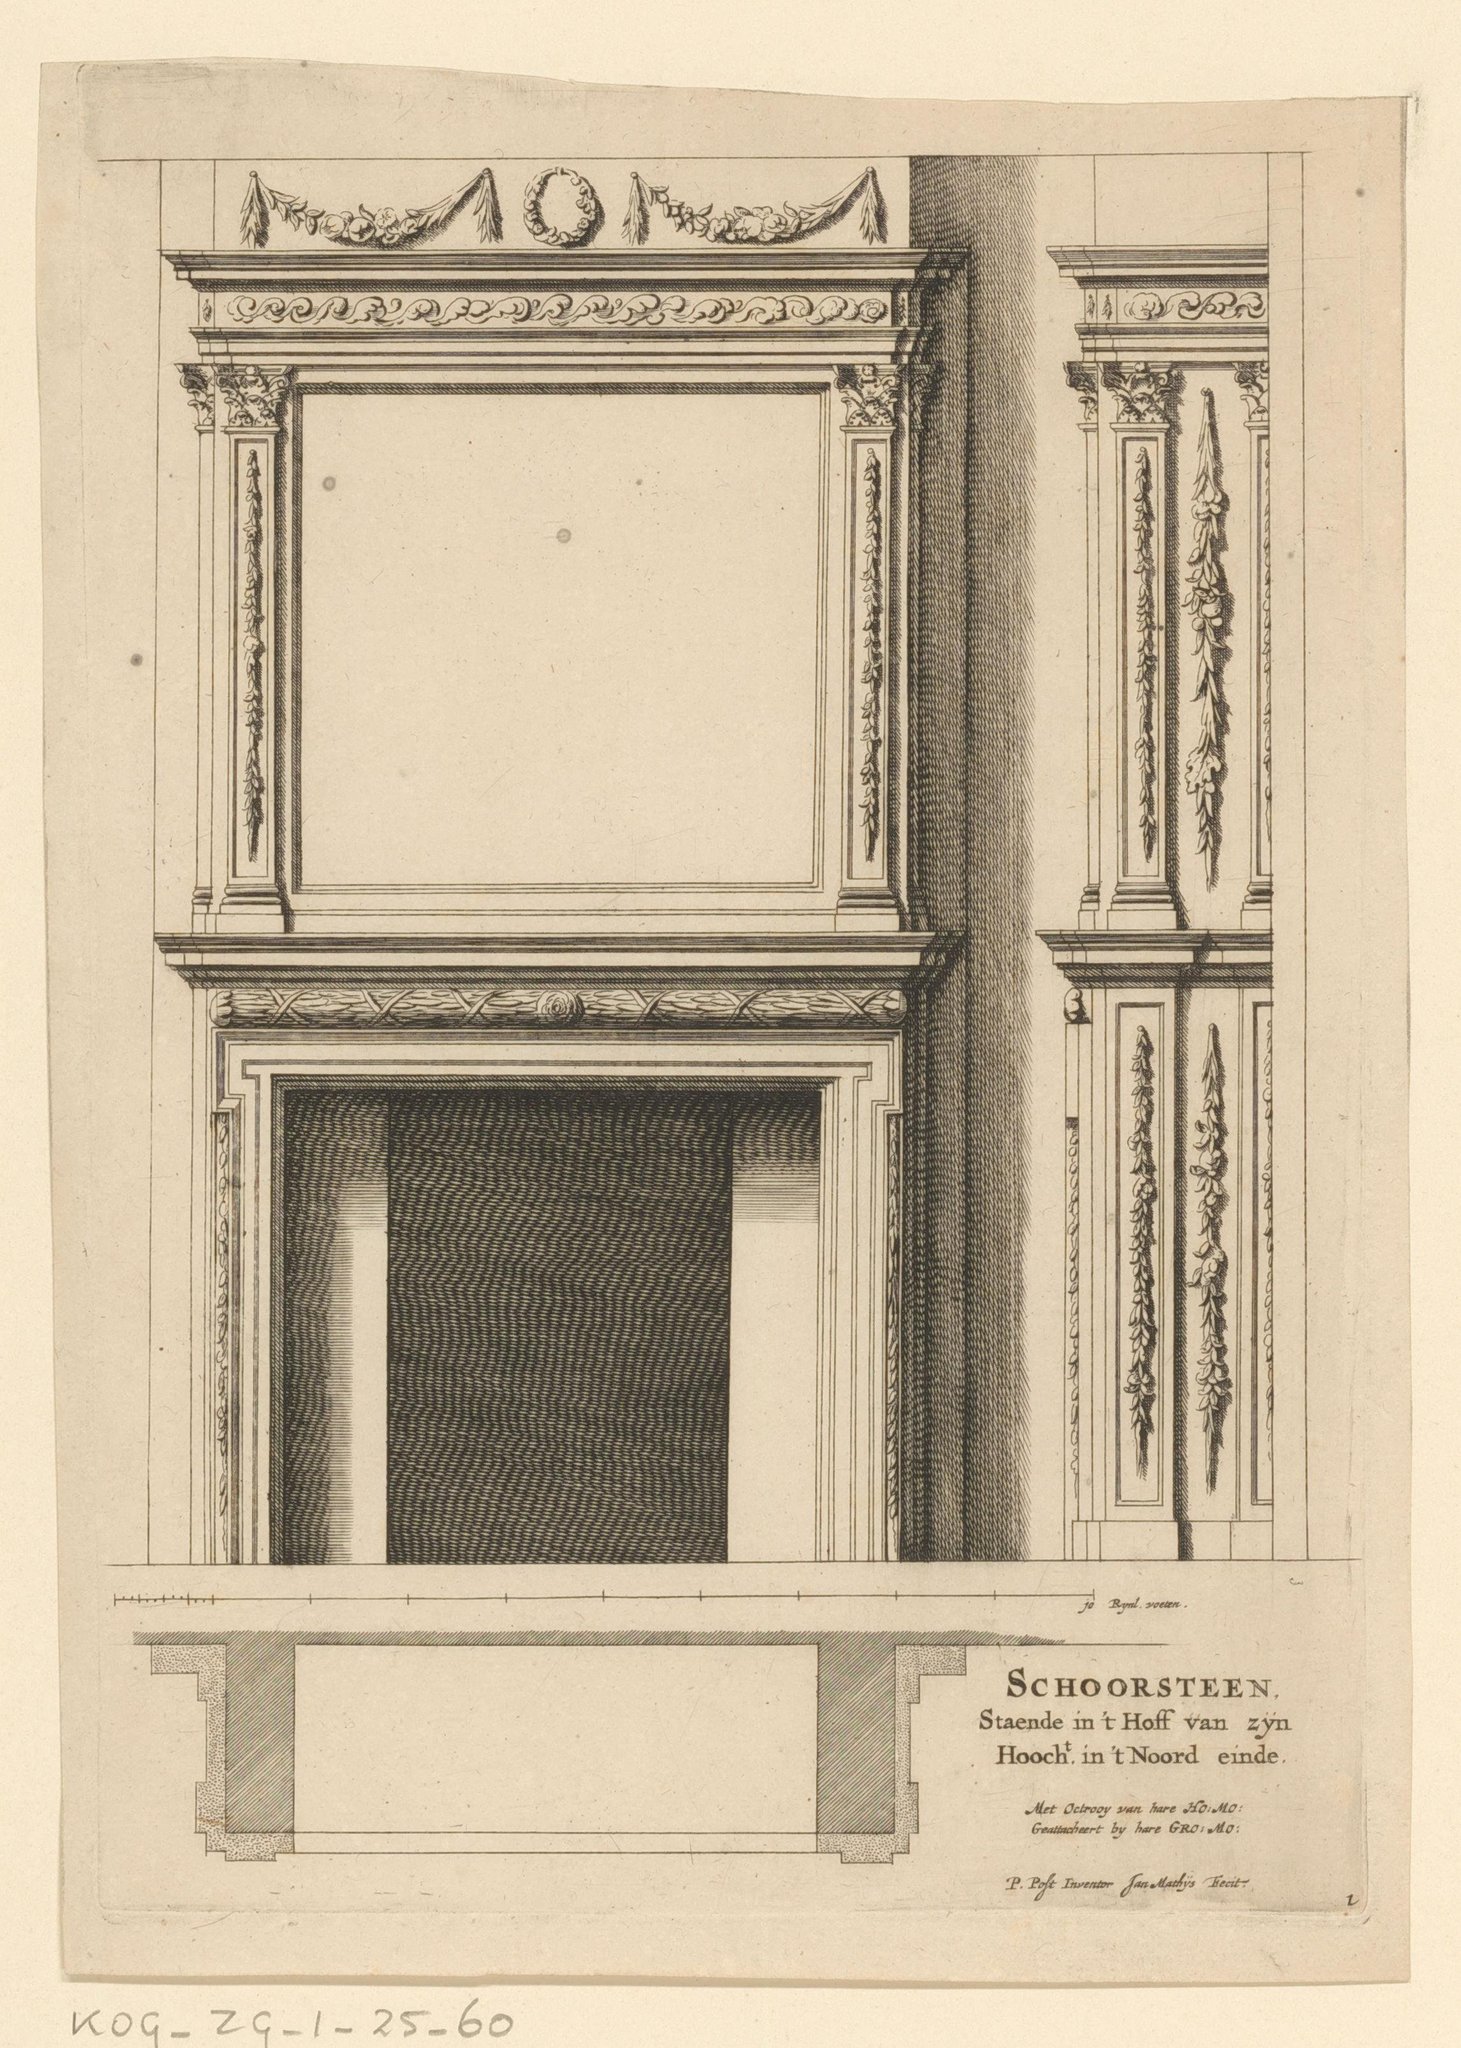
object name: ornament print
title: Schouw, onderboezem en omlijsting van de schoorsteen in Paleis Noordeinde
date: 1669-1706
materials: paper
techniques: engraving, etching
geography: amsterdam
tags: chimney, chimney ornaments, chimney-piece, mantelpiece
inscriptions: stamp:, : ‘Met Octrooy van hare HO: MO: Geattacheert bij hare GRO: MO:’, stamp:, stamp:, collector's mark: Lugt 1641a, collector's mark: Lugt 1641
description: Titelprent is onderdeel van een serie bestaande uit een titelprent en 22 vervolg prenten. De serie is voor het eerst uitgegeven door Pieter Jansz. Post in Den Haag of Rotterdam. De huidige (tweede staat) is uitgegeven door Frederik de Wit tussen 1669 en 1706. De volgorde van de prenten is in deze serie veranderd. De prenten zijn een derde keer uitgegeven door Pieter van der Aa in 1715 te Leiden. Hier is de volgorde wederom aangepast.